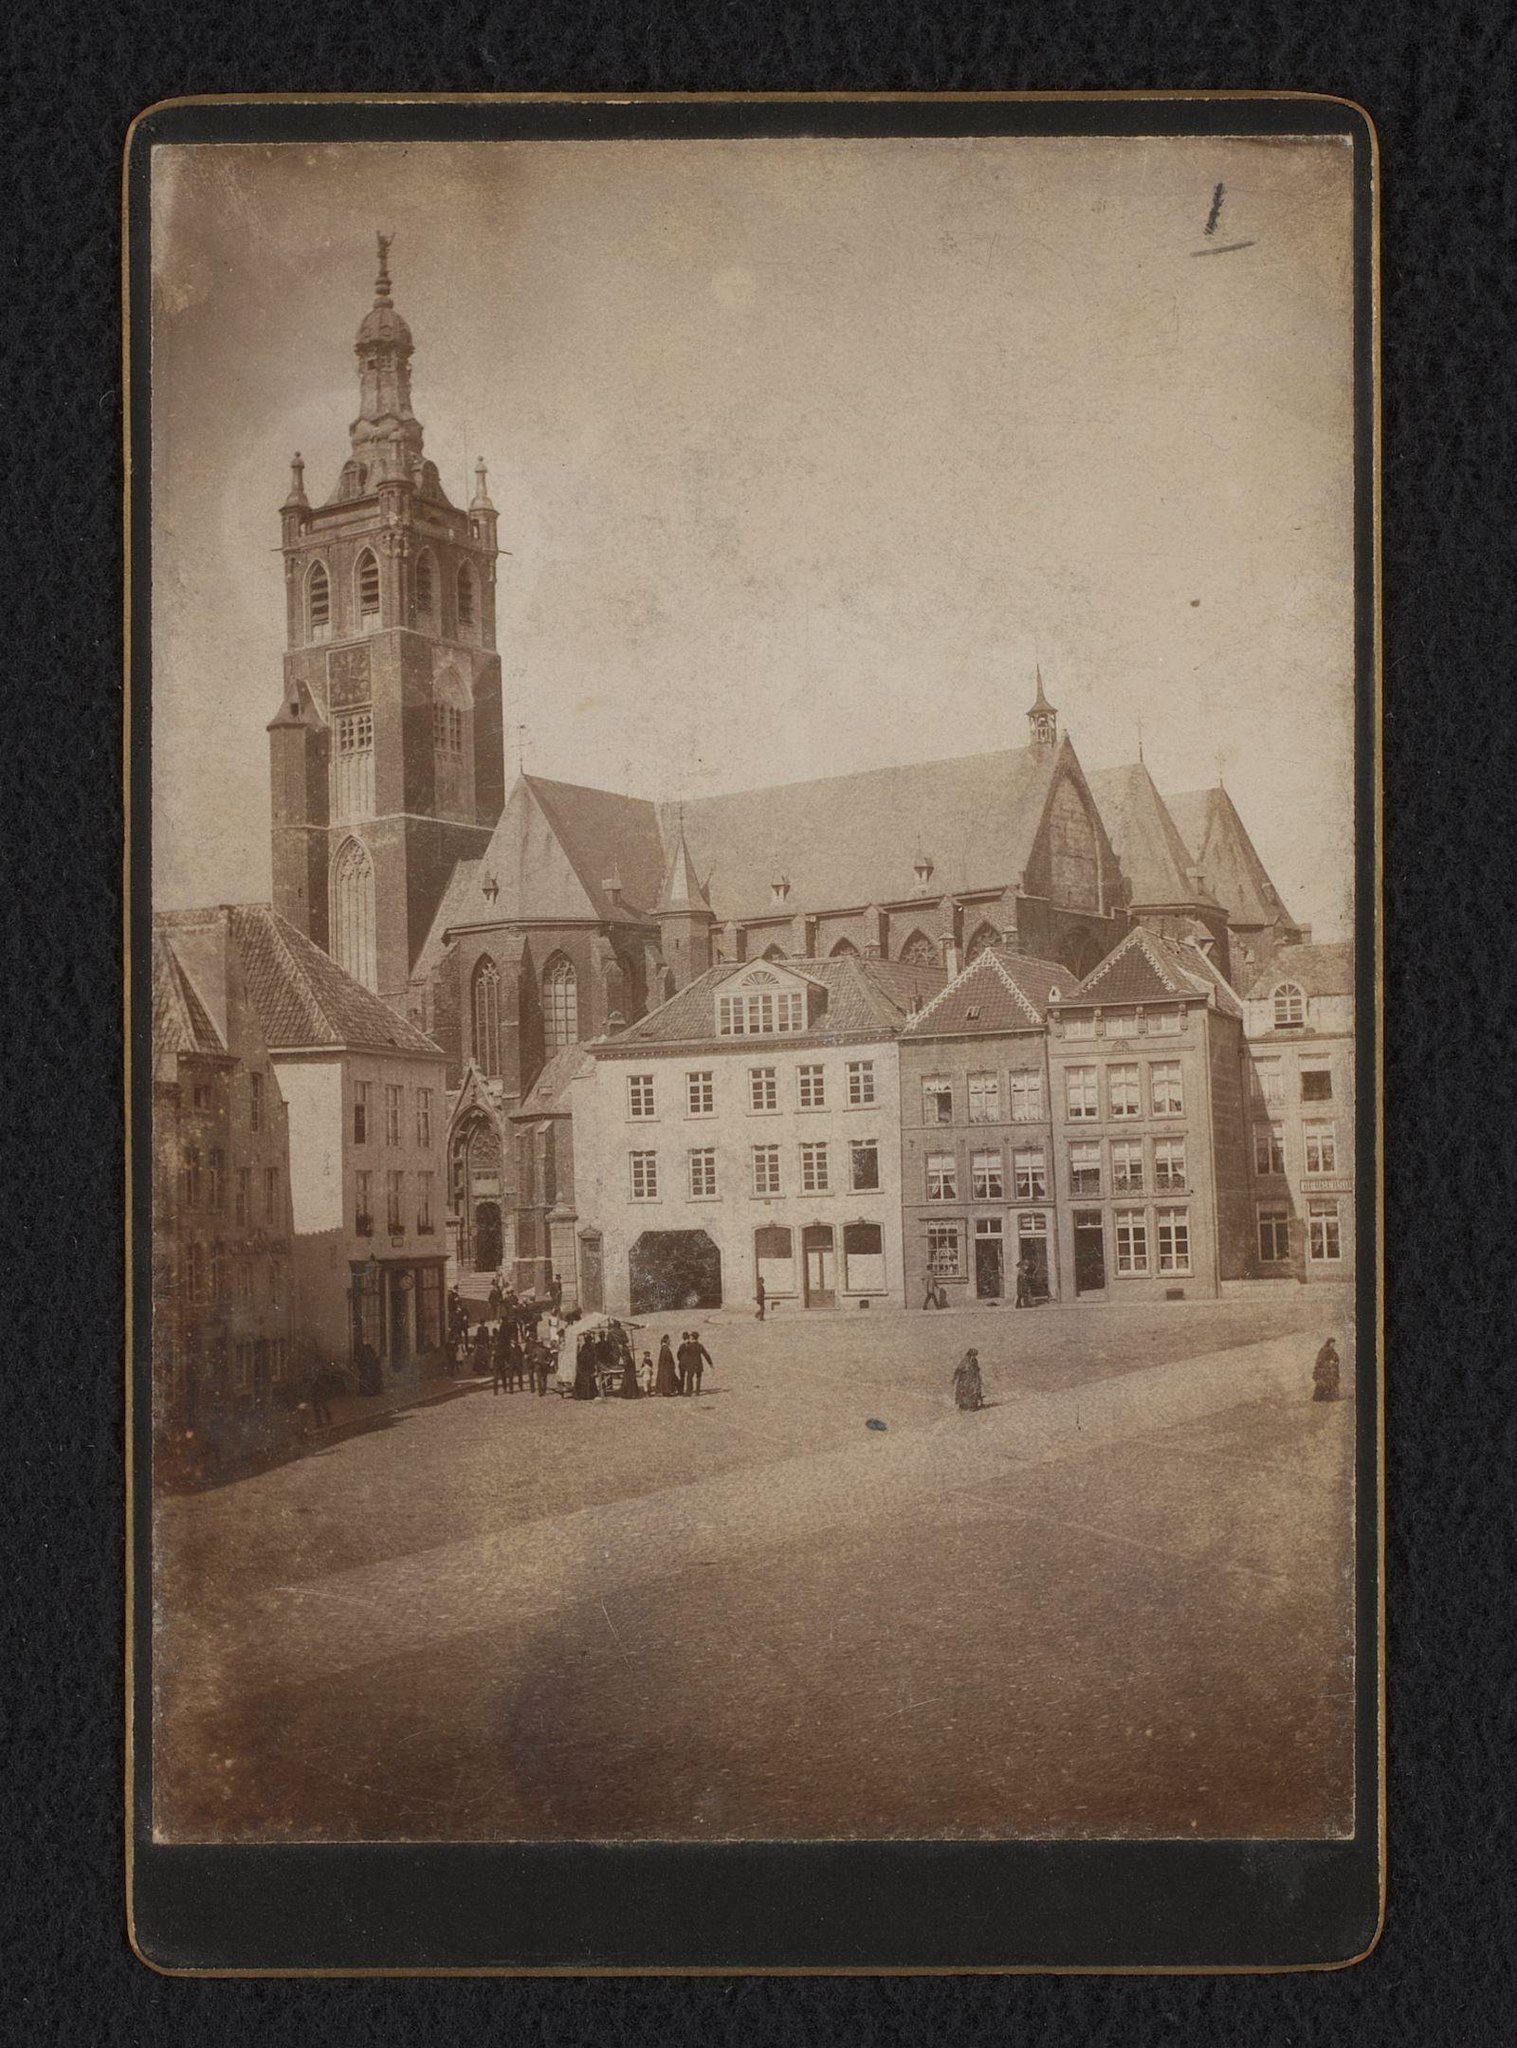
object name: cabinet photograph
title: Gezicht op de Markt en de Sint-Christoffelkathedraal, Roermond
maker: Anonymous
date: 1870-1890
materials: cardboard, paper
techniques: albumen print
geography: roermond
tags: church (exterior), village square, place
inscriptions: number: ‘1’